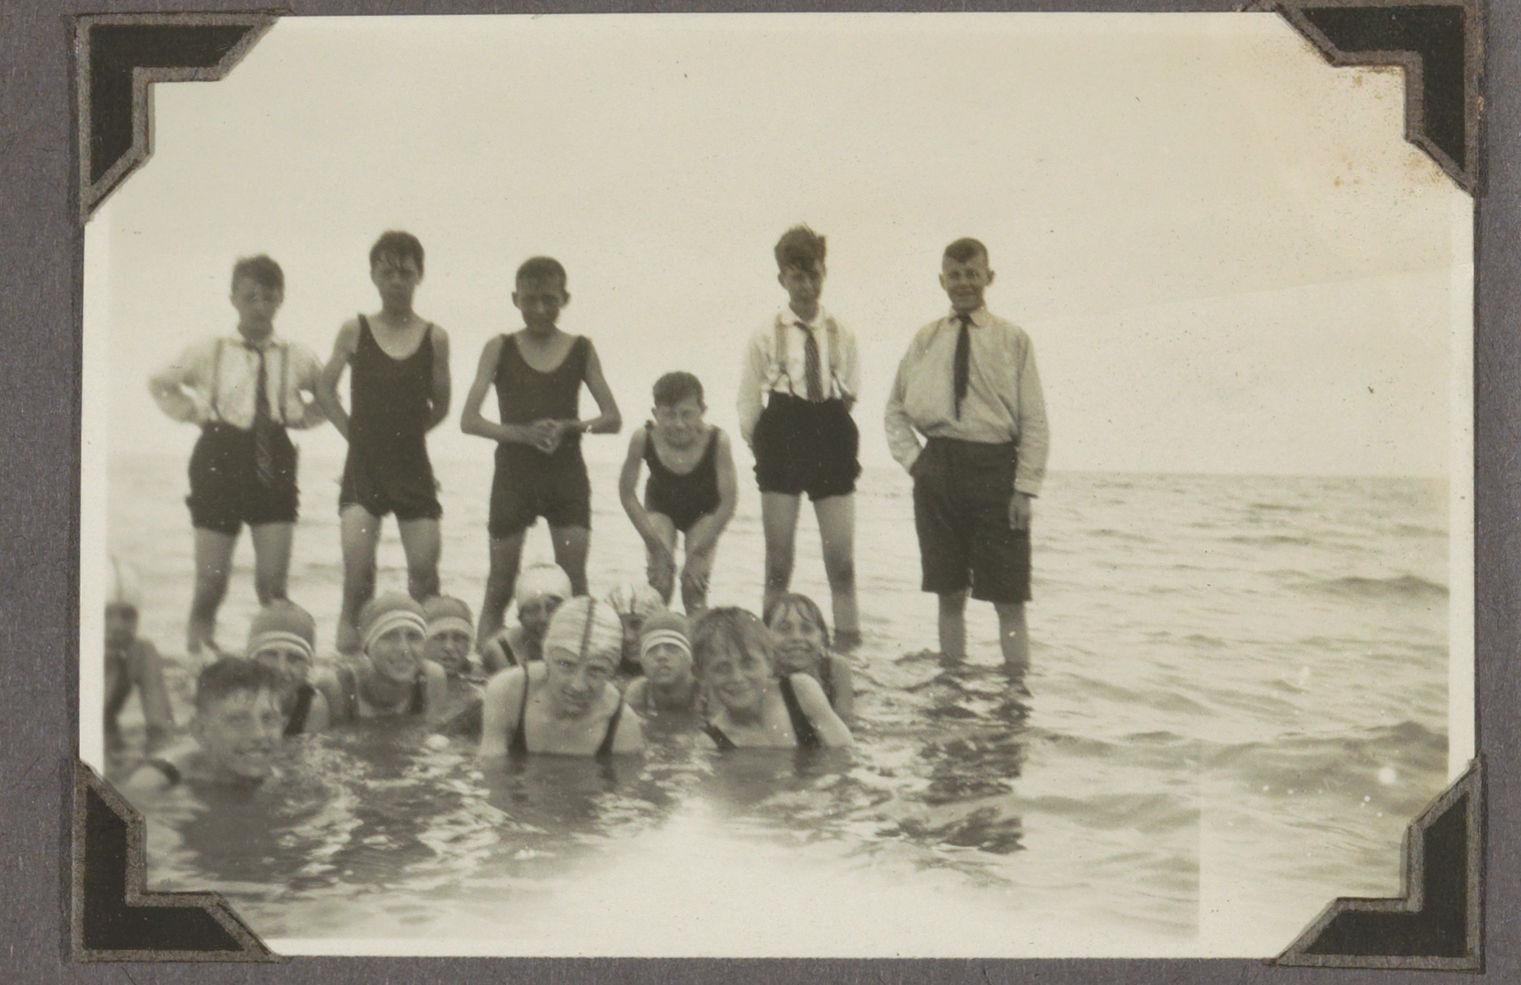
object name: photograph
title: Schoolkinderen aan zee, mogelijk leerlingen van de Planciusschool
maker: Anonymous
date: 1930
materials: photographic support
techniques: gelatin silver print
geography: netherlands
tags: beach (as place of recreation), elementary school; class, form, netherlands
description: Onderdeel van Fotoalbum met opnames van vakanties in Zuid-Frankrijk.